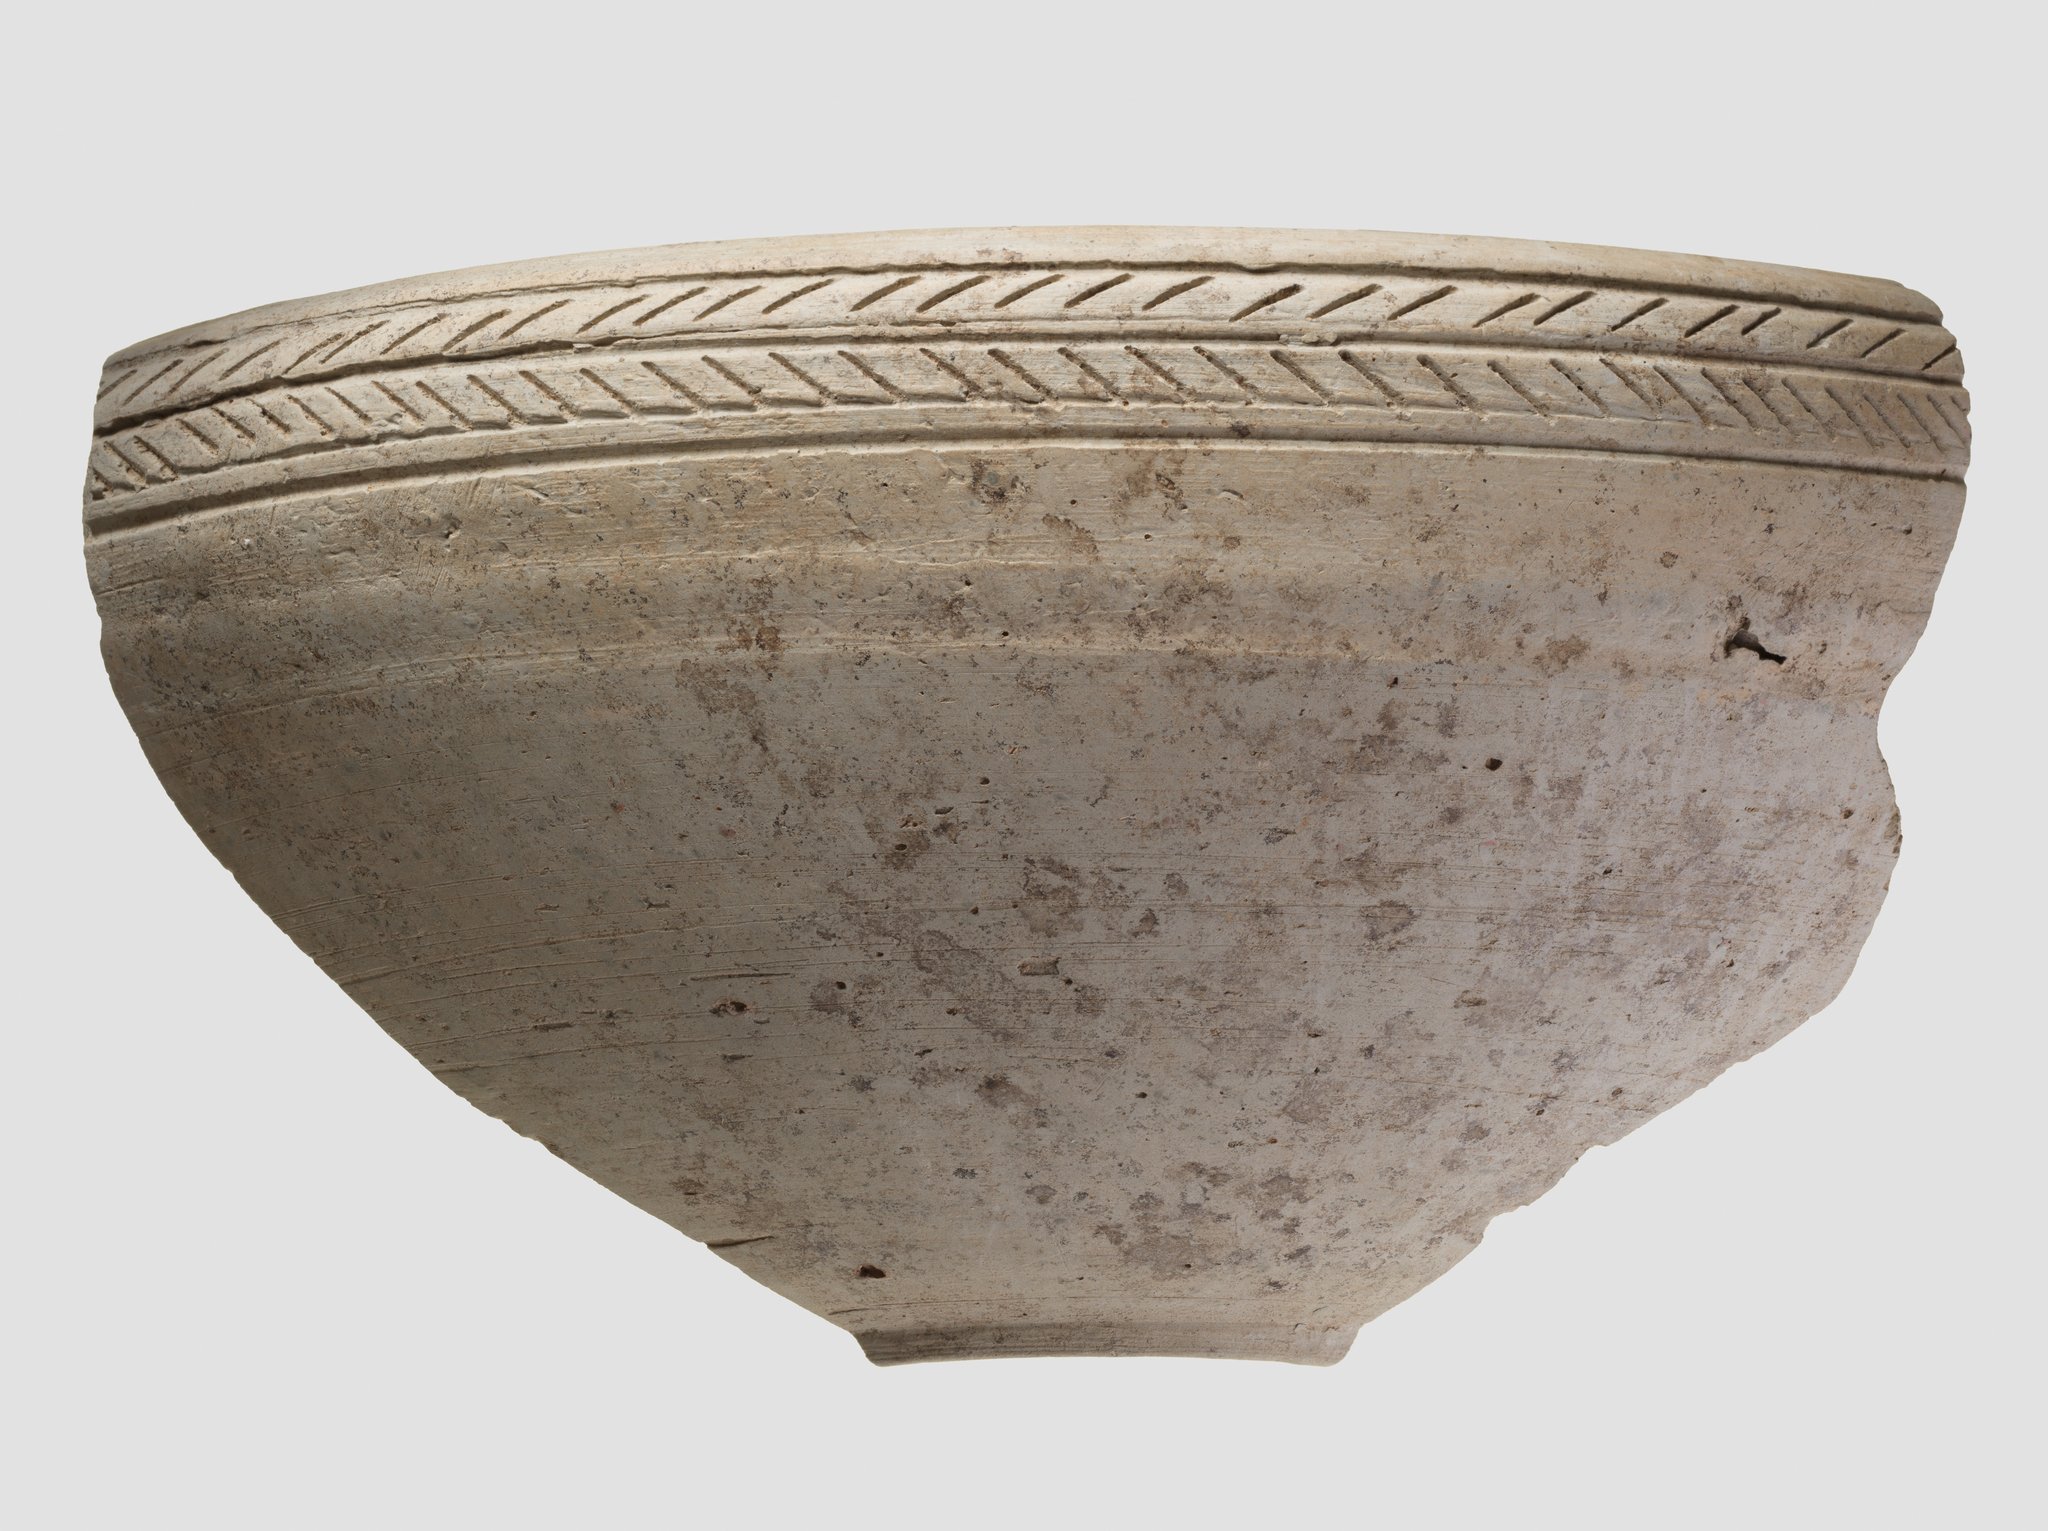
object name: bowl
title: Bowl rim sherd with incised decoration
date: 2333-2001 BCE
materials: ceramic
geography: mesopotamia